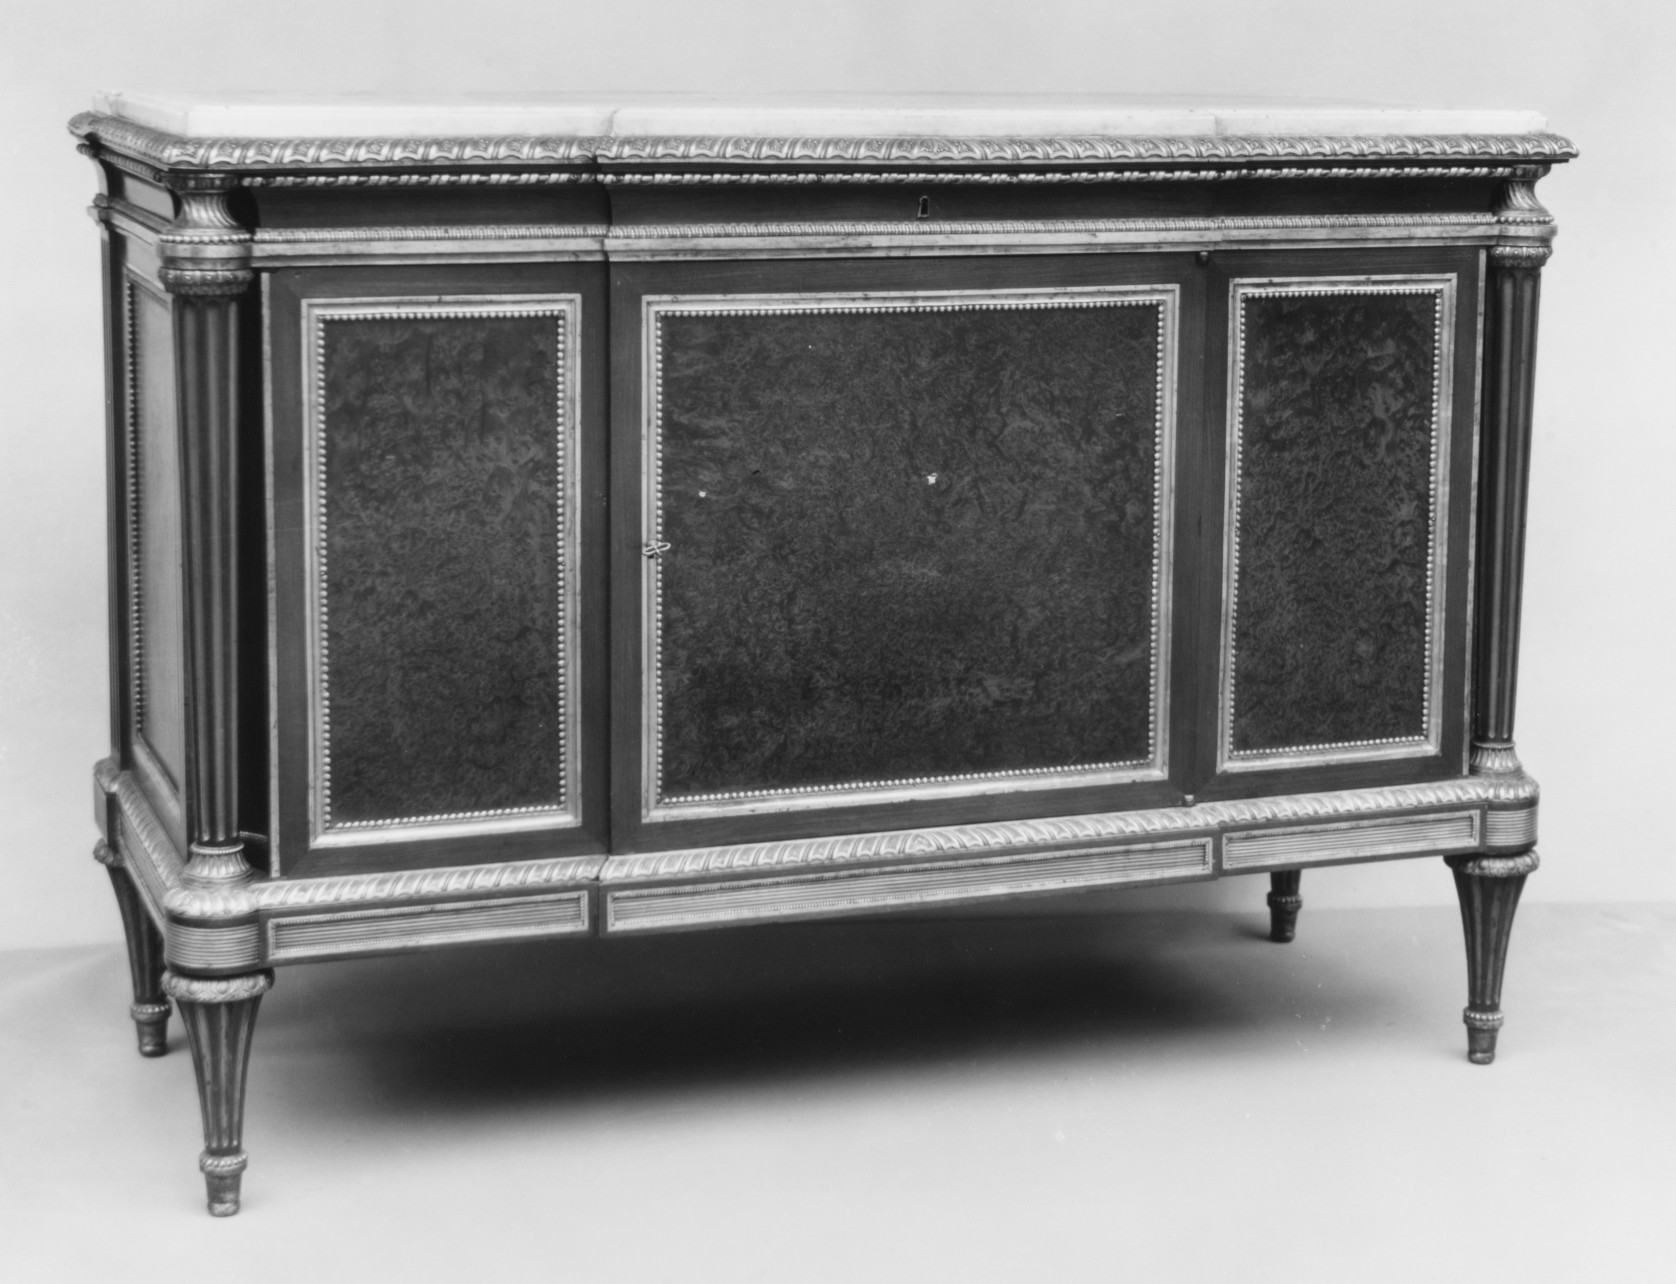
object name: commode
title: Commode (commode à vantaux)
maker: adam weisweiler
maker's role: maker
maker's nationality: french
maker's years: 1744-1820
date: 1785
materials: gilt bronze, wood, marble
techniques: veneering